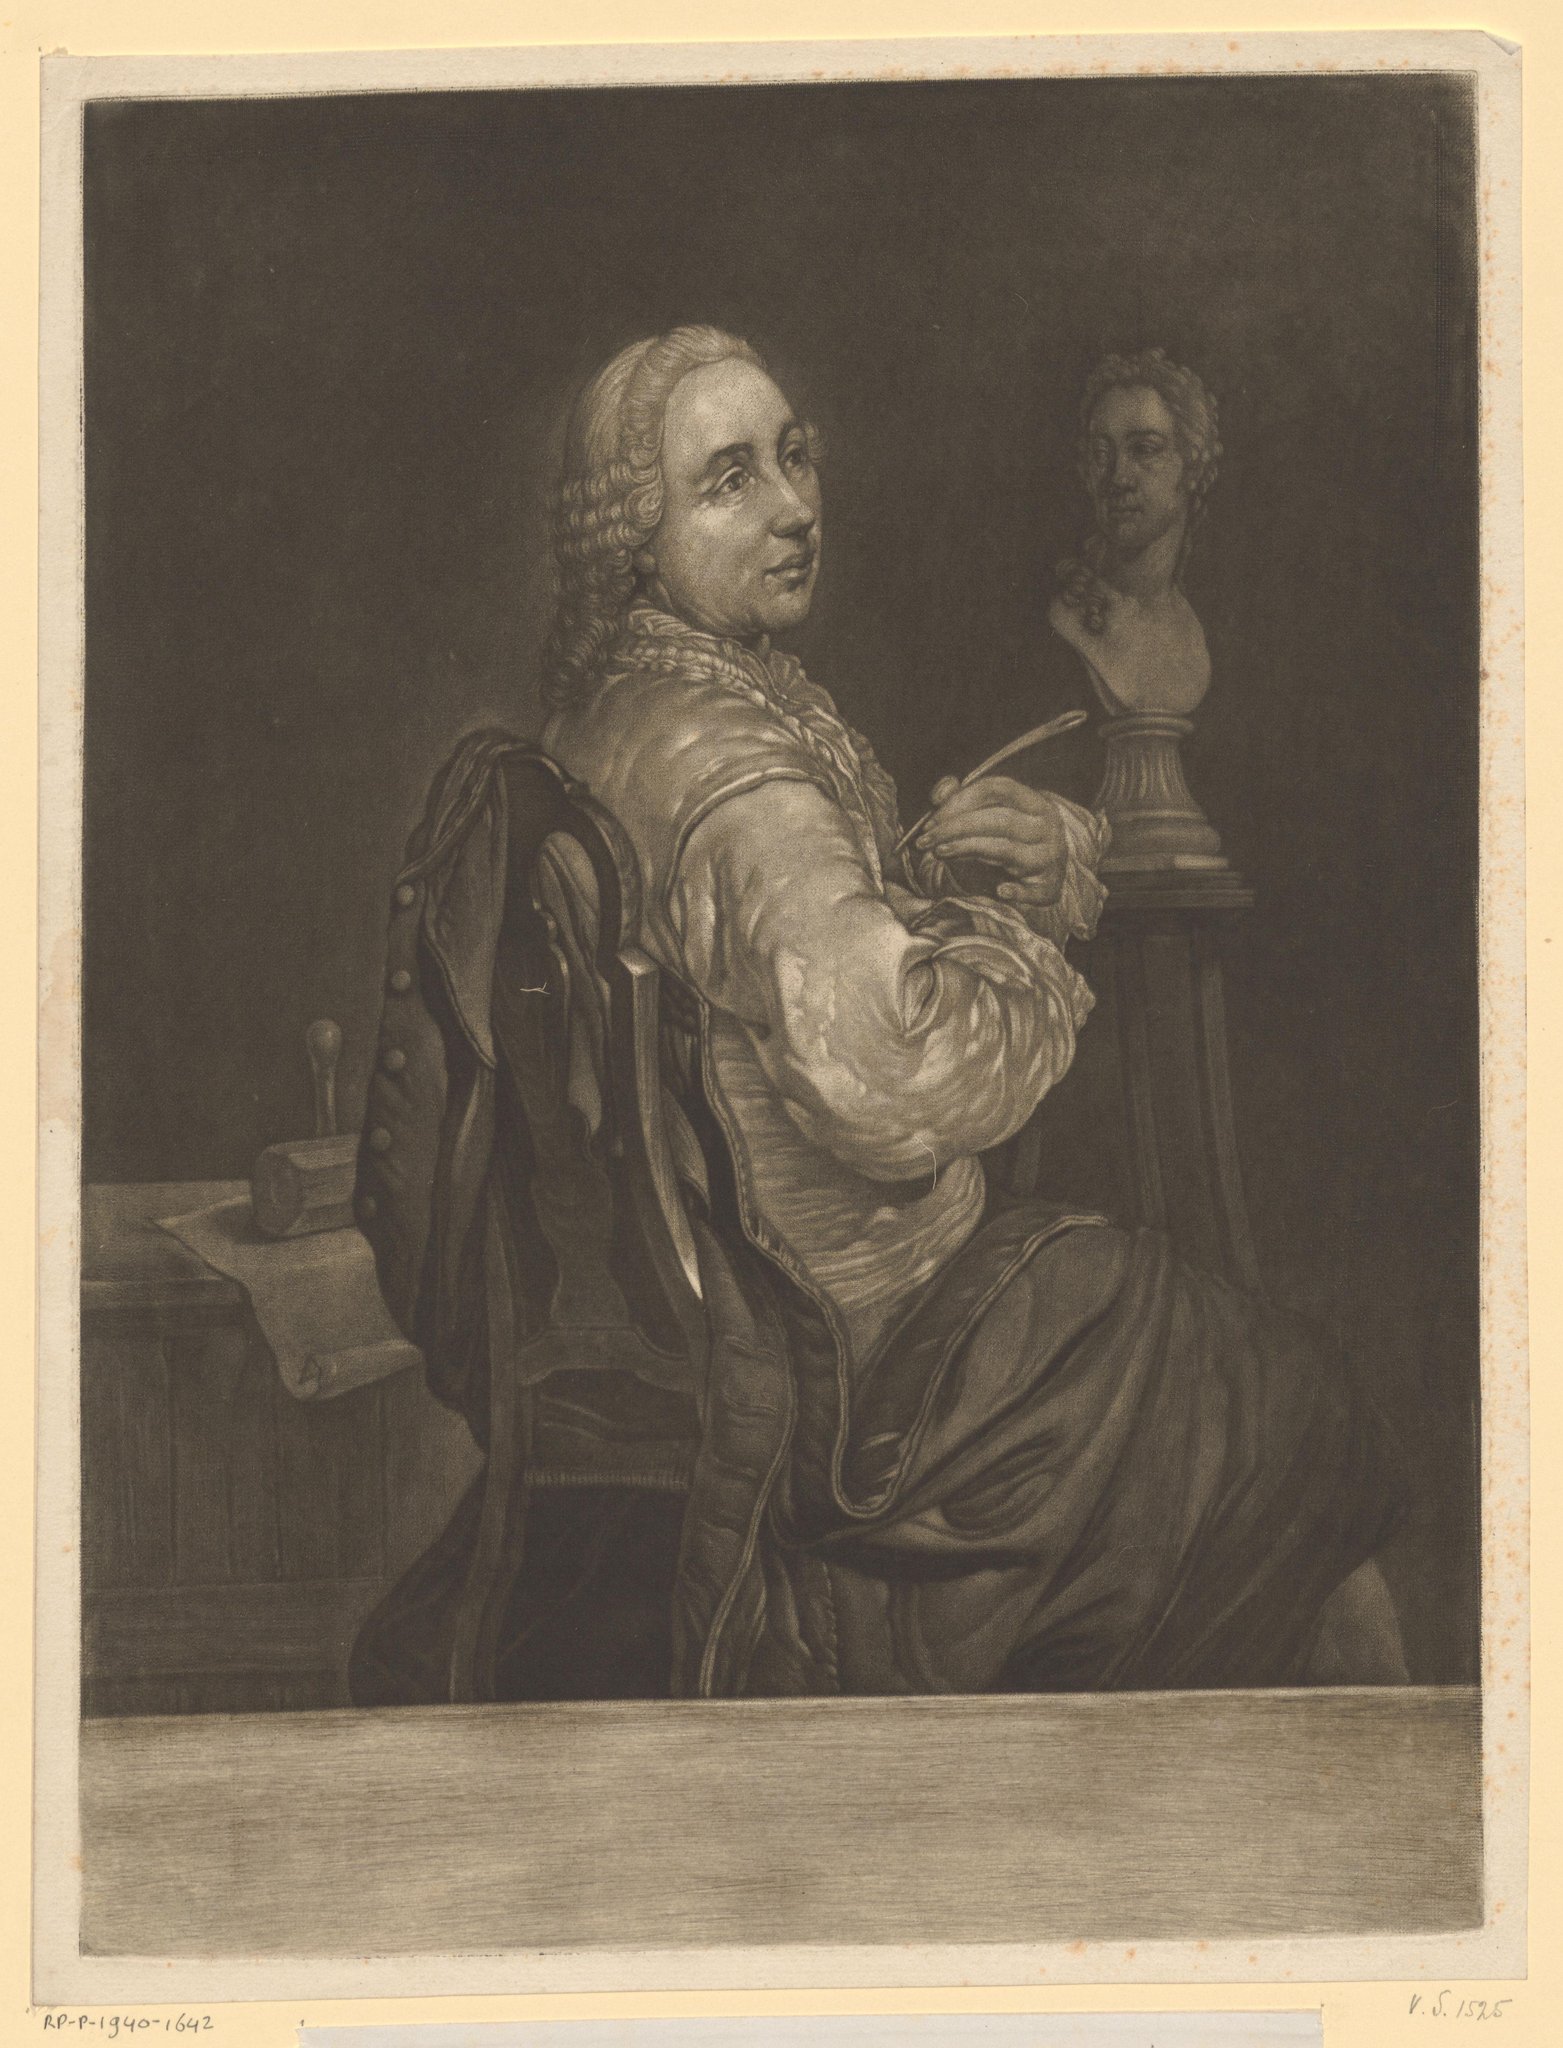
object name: print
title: Portret van Willem Dubbelens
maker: pieter anthony wakkerdak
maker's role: print maker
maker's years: 1729-1774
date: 1739-1774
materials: paper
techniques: mezzotint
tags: portrait, self-portrait of sculptor, historical persons, tools, implements of sculptor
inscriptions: collector's mark: Lugt 2760, collector's mark: Lugt 2166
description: Op hetzelfde opzetvel van deze prent is een tweede blad bevestigd met een beschrijving van de tekst die op de latere staat van de prent is gebruikt.